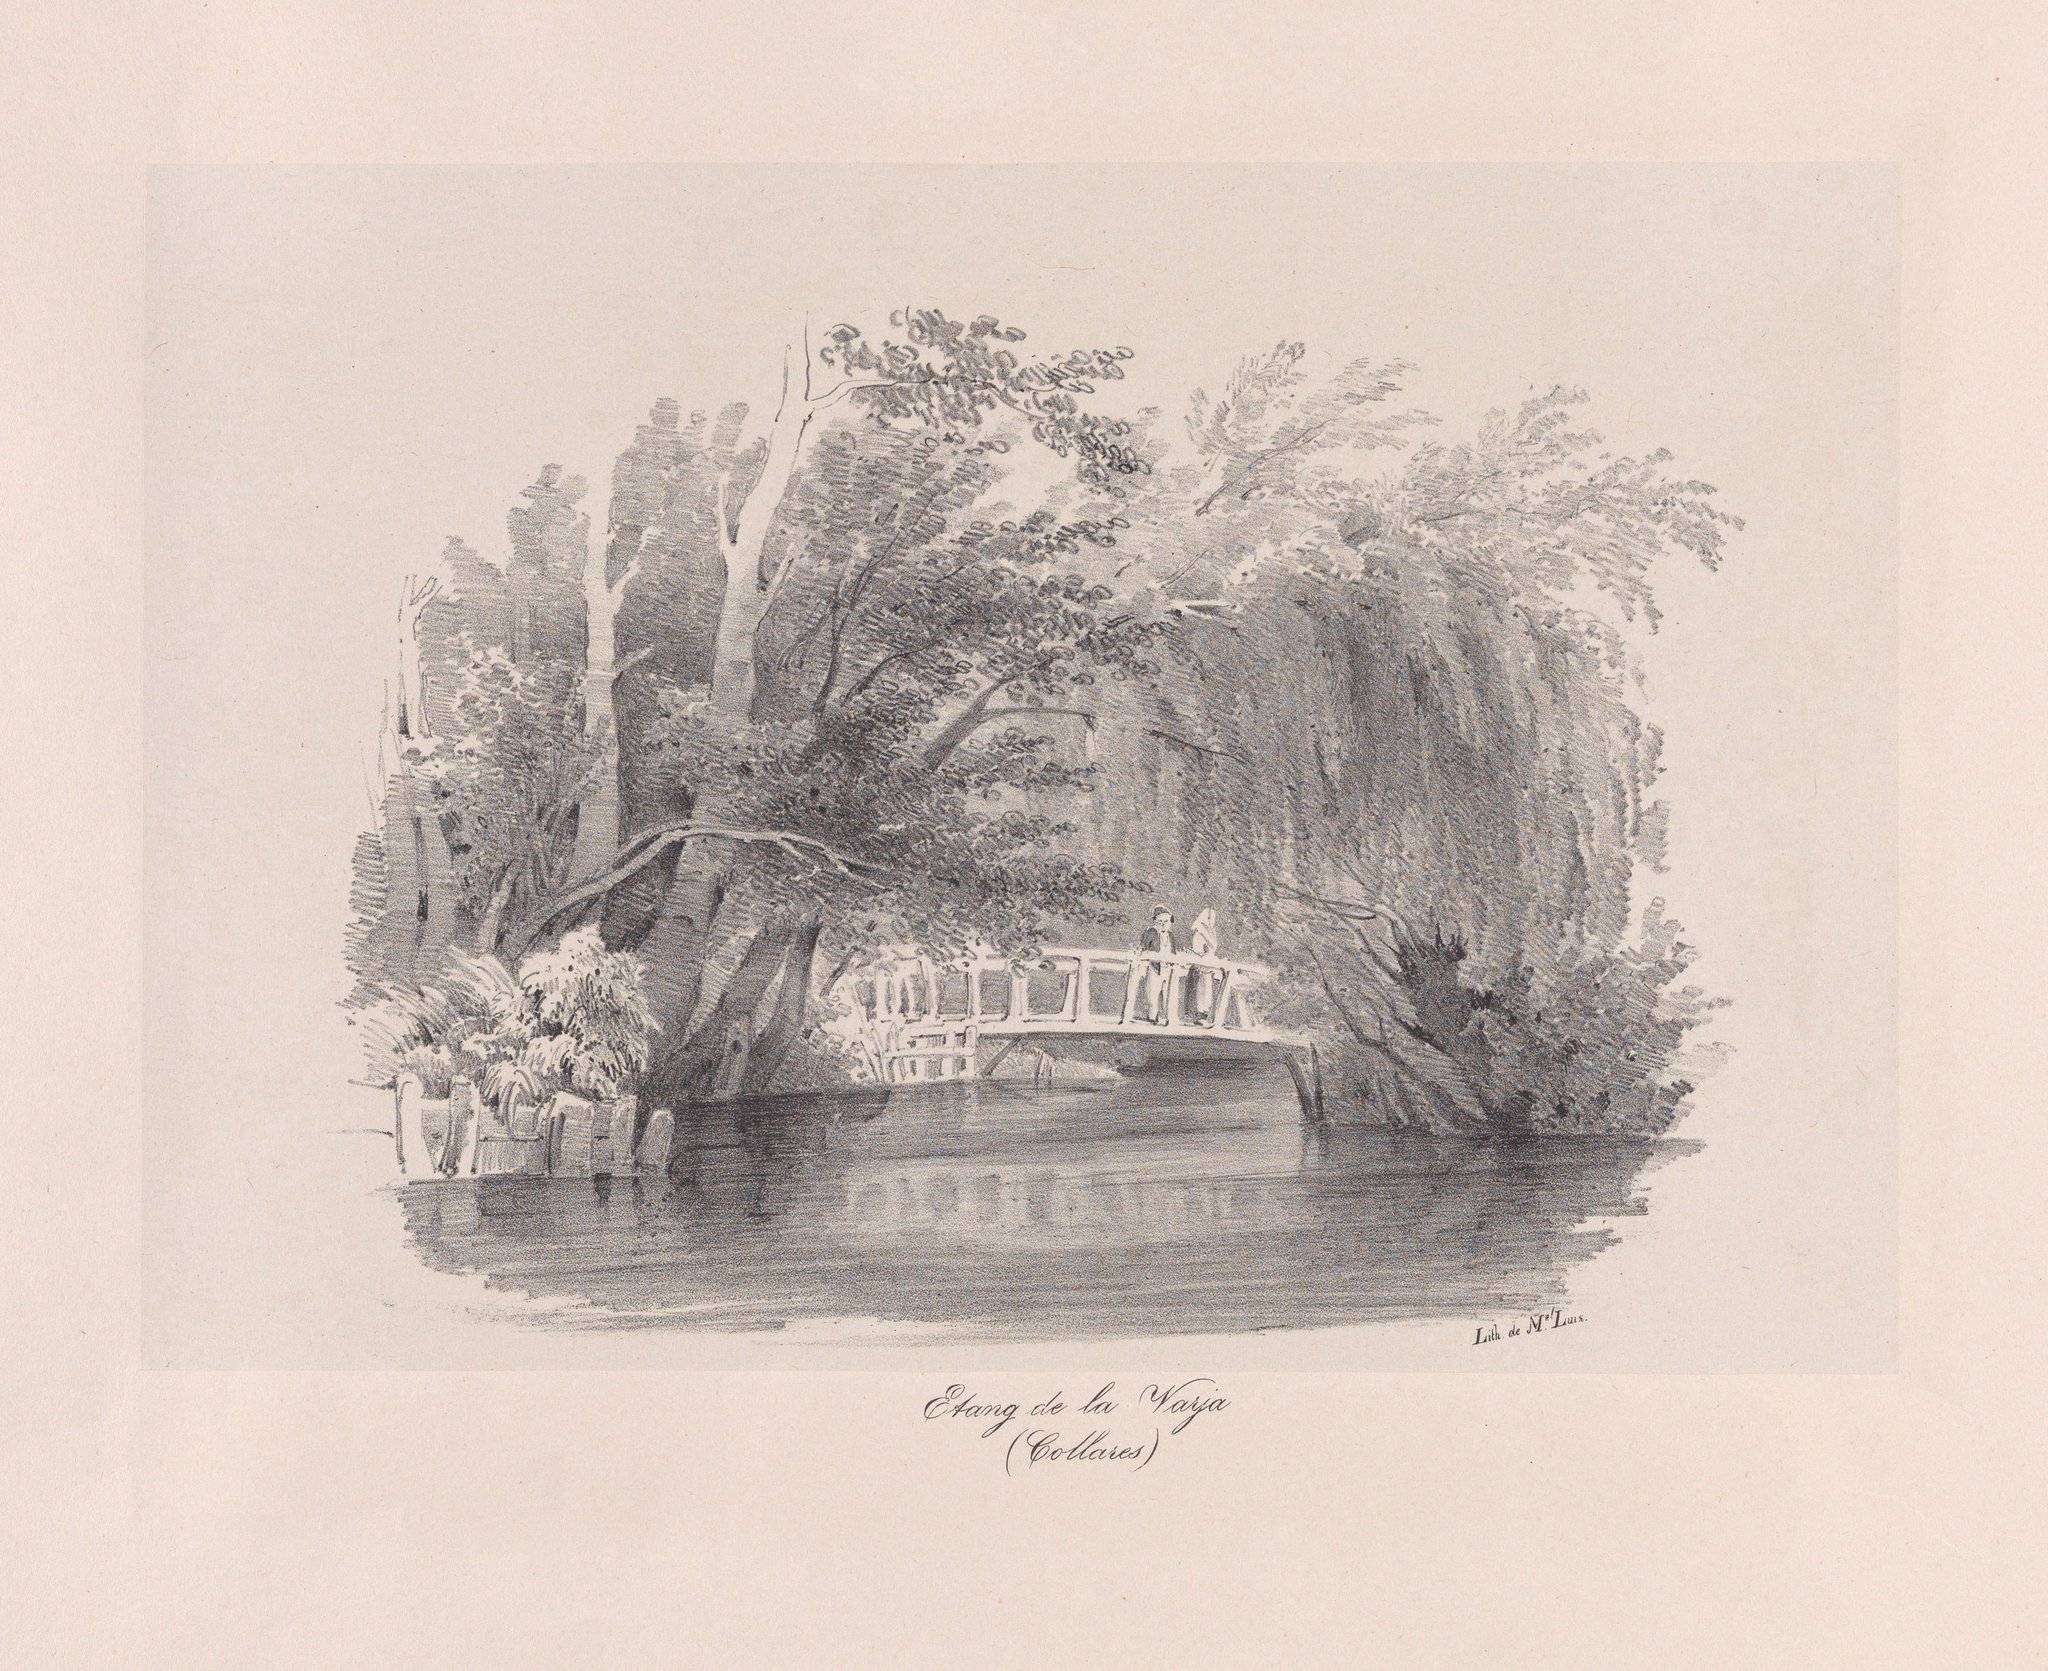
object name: print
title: View of a bridge over the Colares river near Sintra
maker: clementine de brelaz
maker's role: artist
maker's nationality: portuguese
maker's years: 1811-1892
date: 1840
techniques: printmaking, lithograph